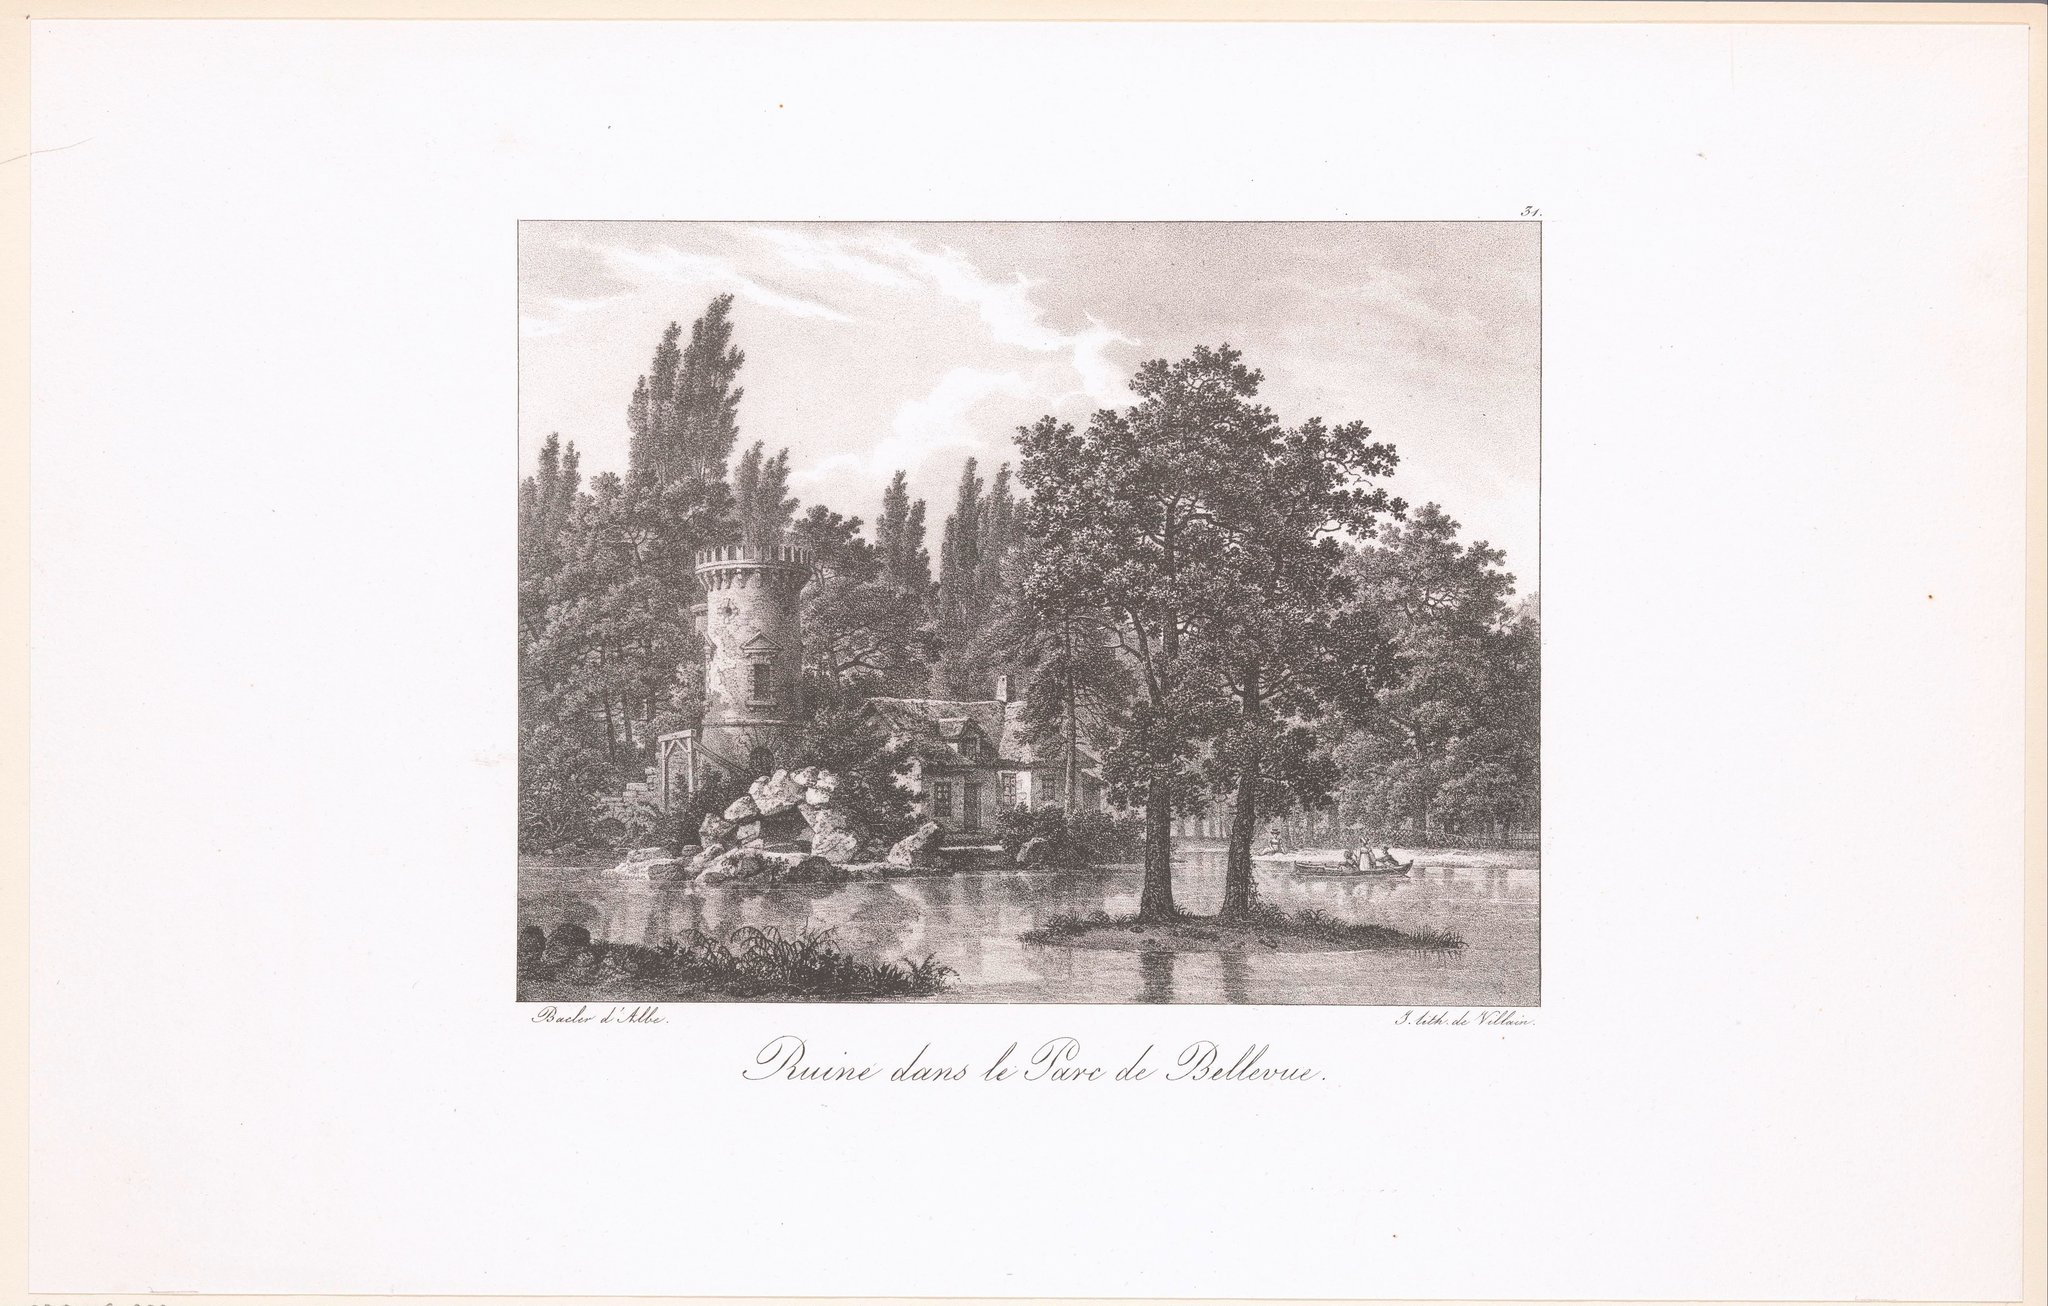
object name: print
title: Promenades pittoresques et lithographiques dans Paris et ses environs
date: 1822-1824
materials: paper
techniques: lithograph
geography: paris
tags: ruins (garden ornaments), ruin of a building ~ architecture, pond, pool, wood and park (as places of recreation)